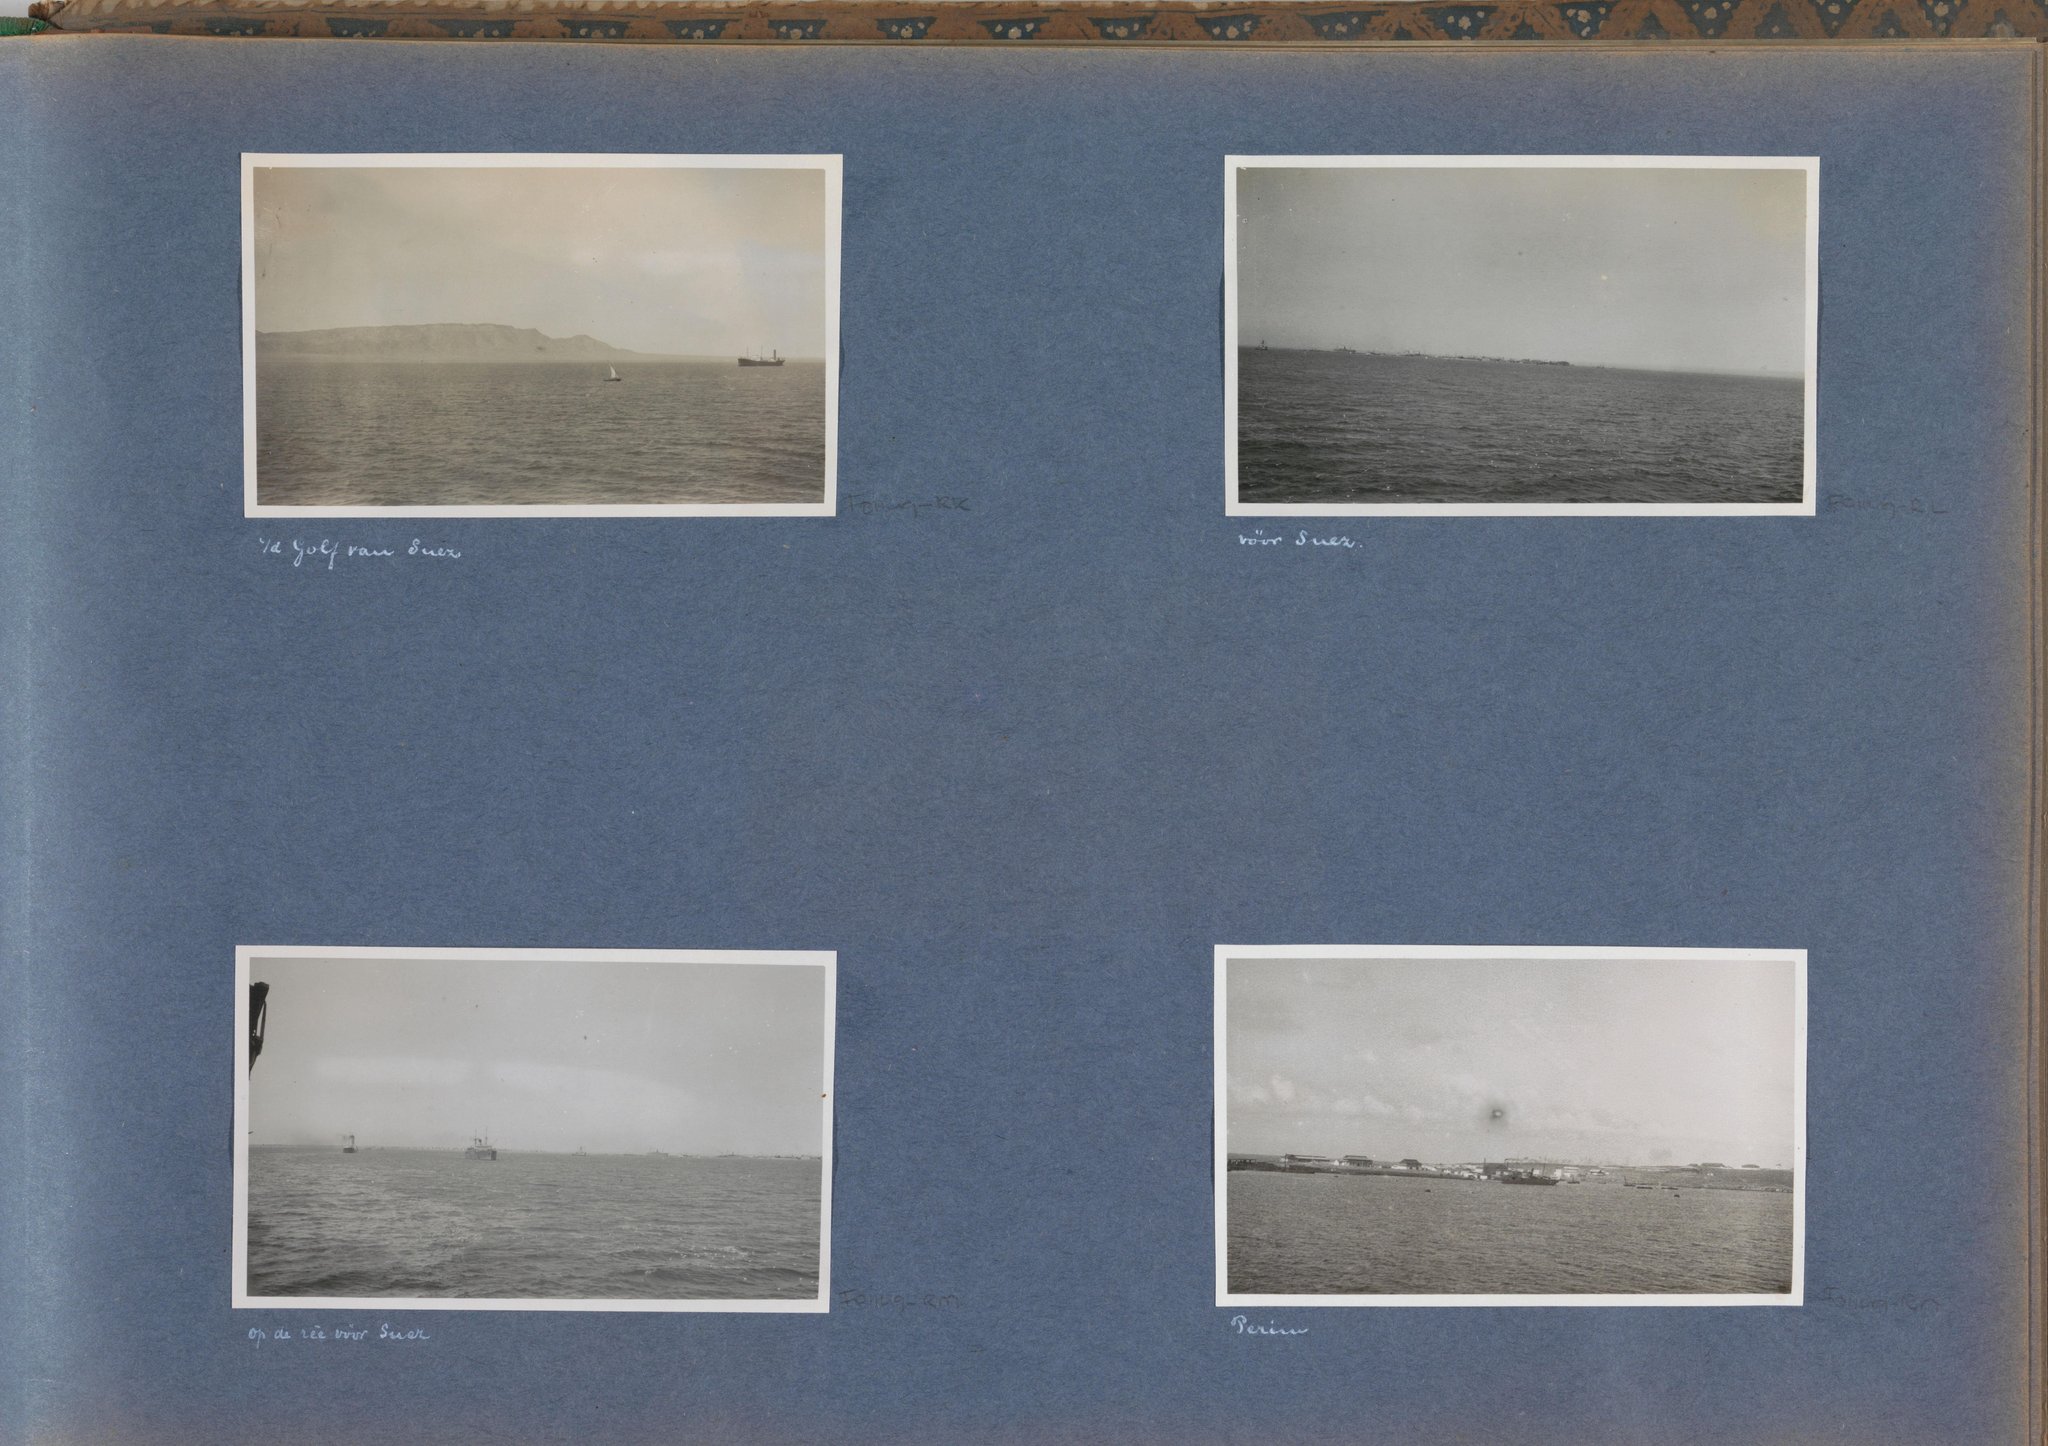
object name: album leaf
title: Golf van Suez met aan de horizon schepen en (vermoedelijk) Suez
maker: Anonymous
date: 1900-1920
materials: paper, photographic support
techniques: gelatin silver print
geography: red sea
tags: sea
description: Onderdeel van reisalbum met foto's van bedrijvigheid en bezienswaardigheden op Sumatra en Java en van de reis naar en van Nederlands-Indië.